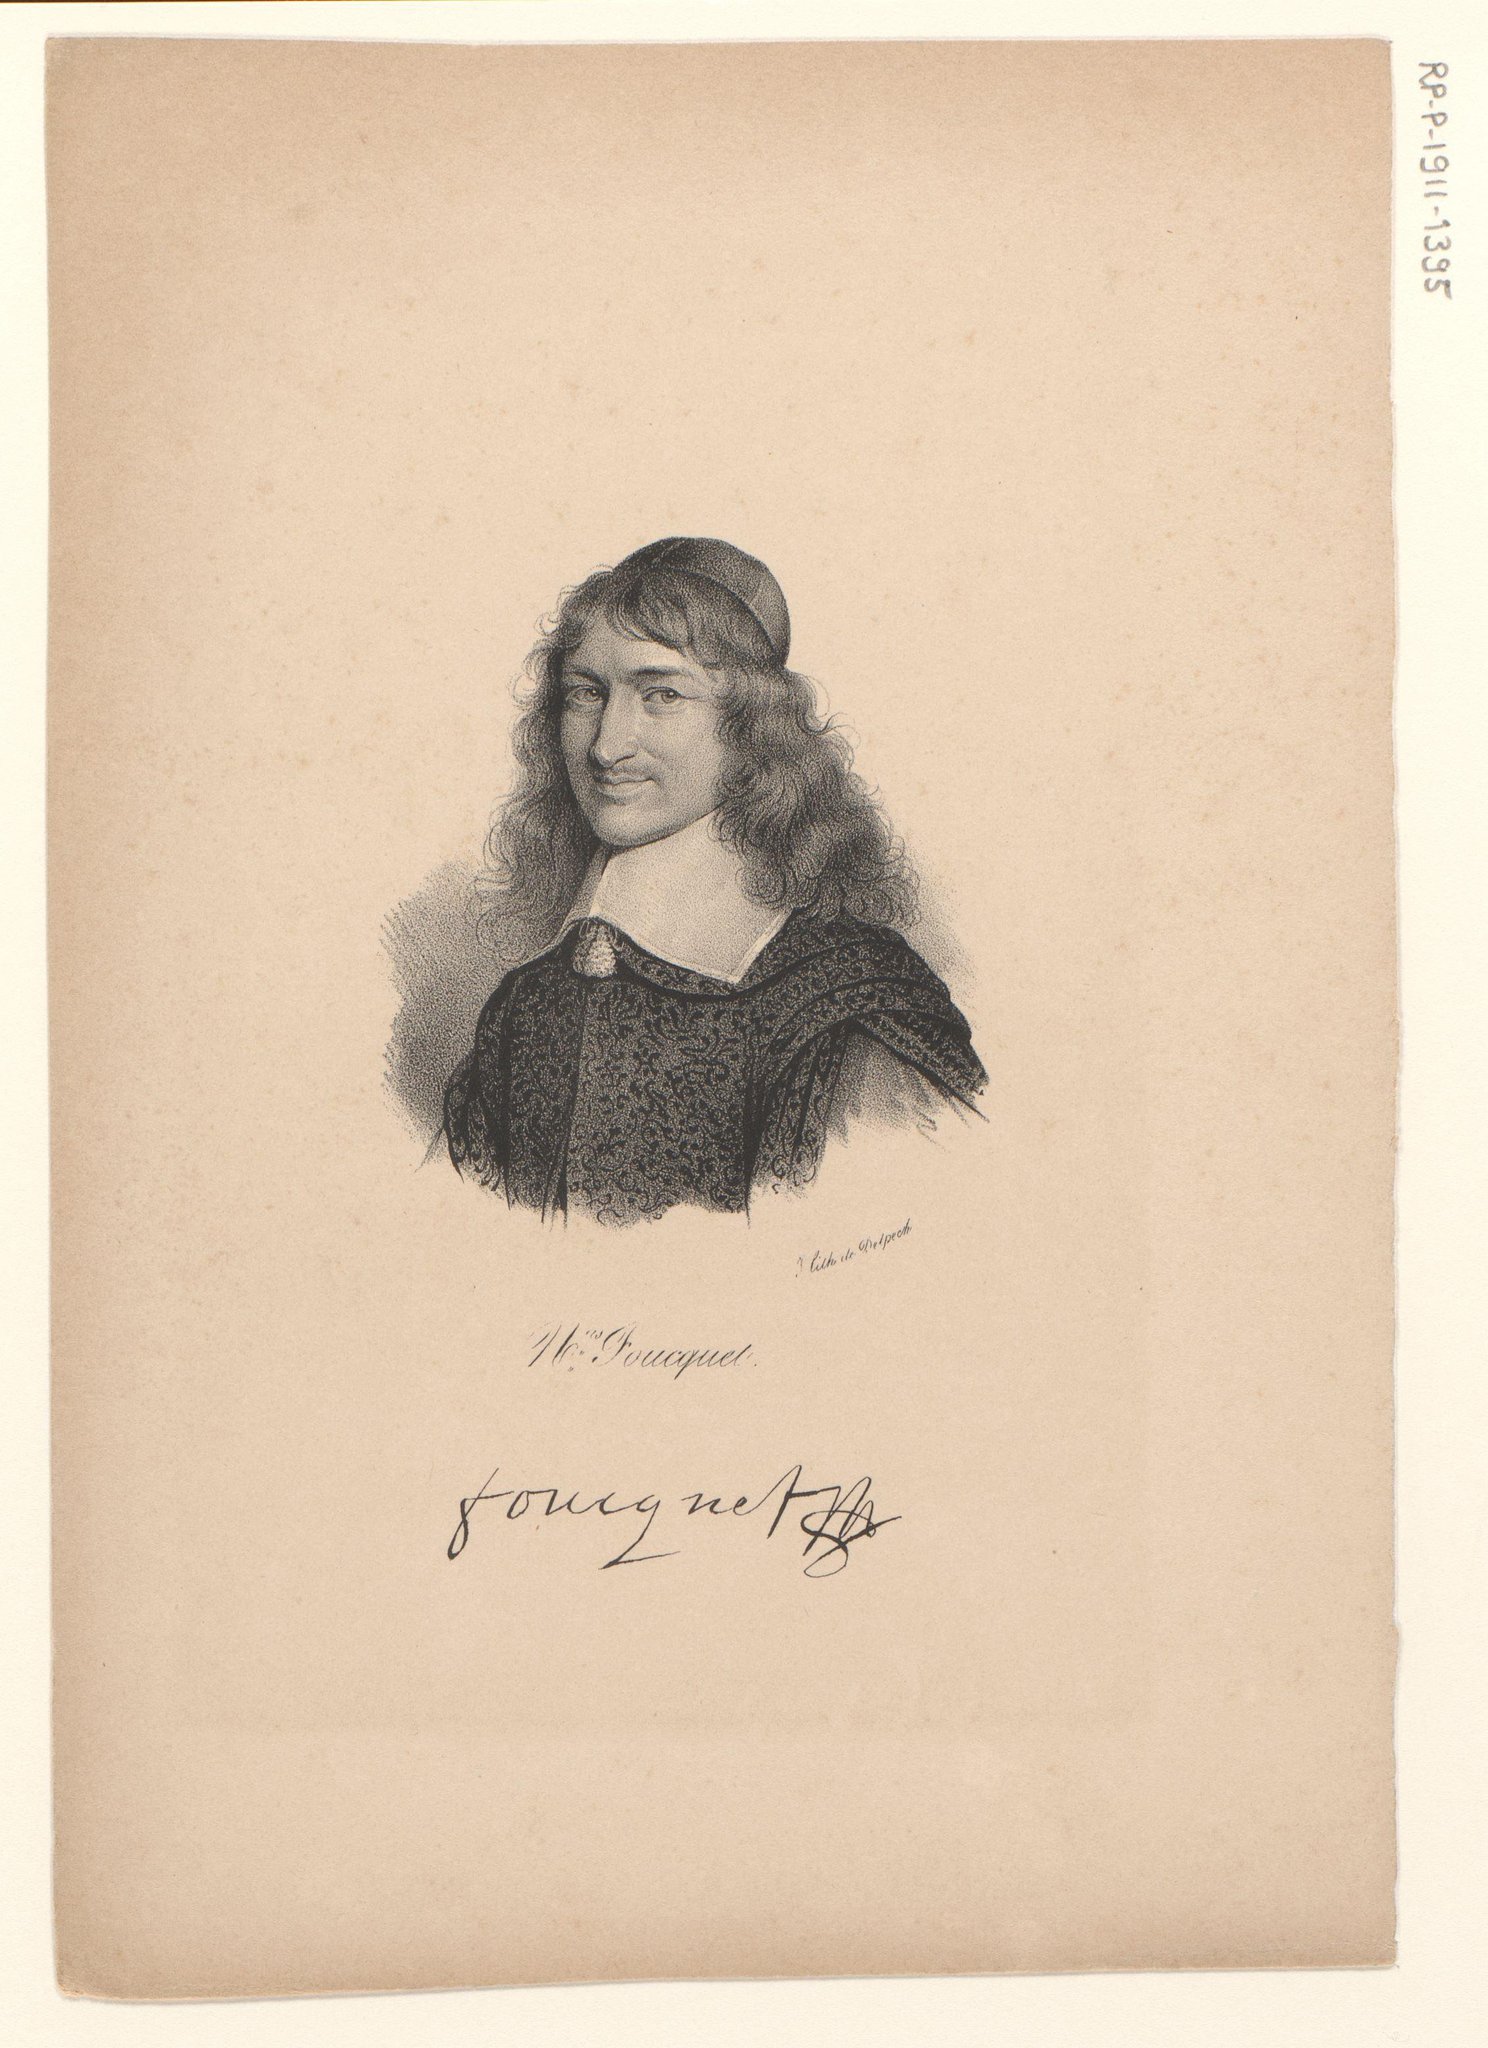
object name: print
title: Portret van Nicolas Fouquet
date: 1818-1842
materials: paper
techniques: lithograph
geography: paris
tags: paris, france, politician, nicolas fouquet, historical persons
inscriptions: collector's mark: Lugt 2228a